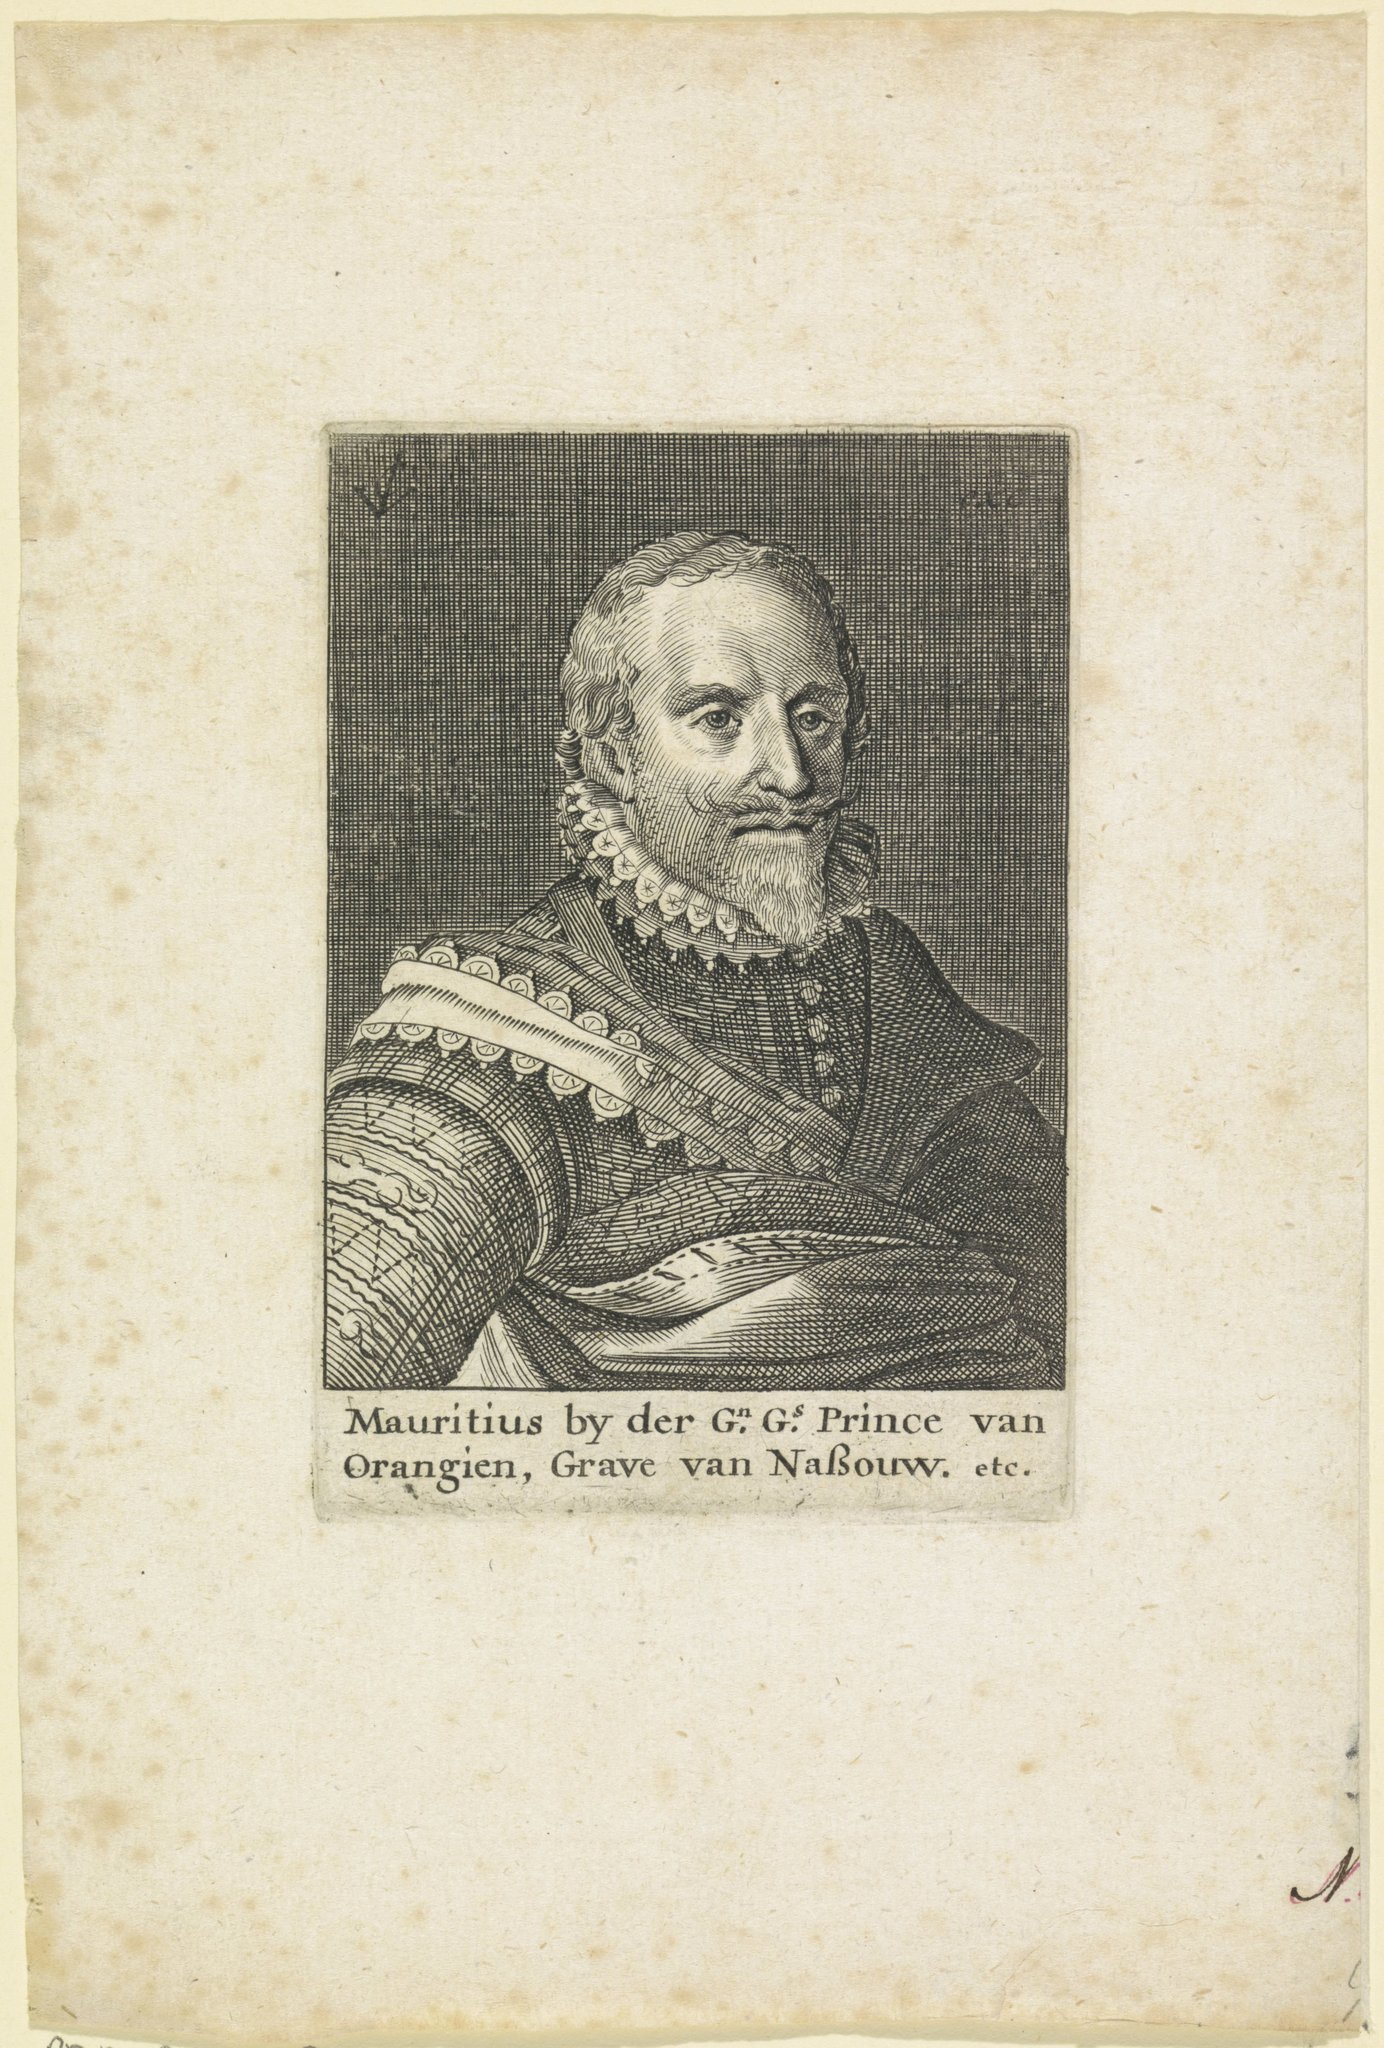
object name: print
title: Portret van Maurits, prins van Oranje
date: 1601-1652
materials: paper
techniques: engraving, etching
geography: low countries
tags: maurice (prince of orange)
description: De hier vermelde titel verwijst naar de hoogst verkregen titel van de geportretteerde, niet per se naar de titel die de geportretteerde op deze voorstelling draagt.